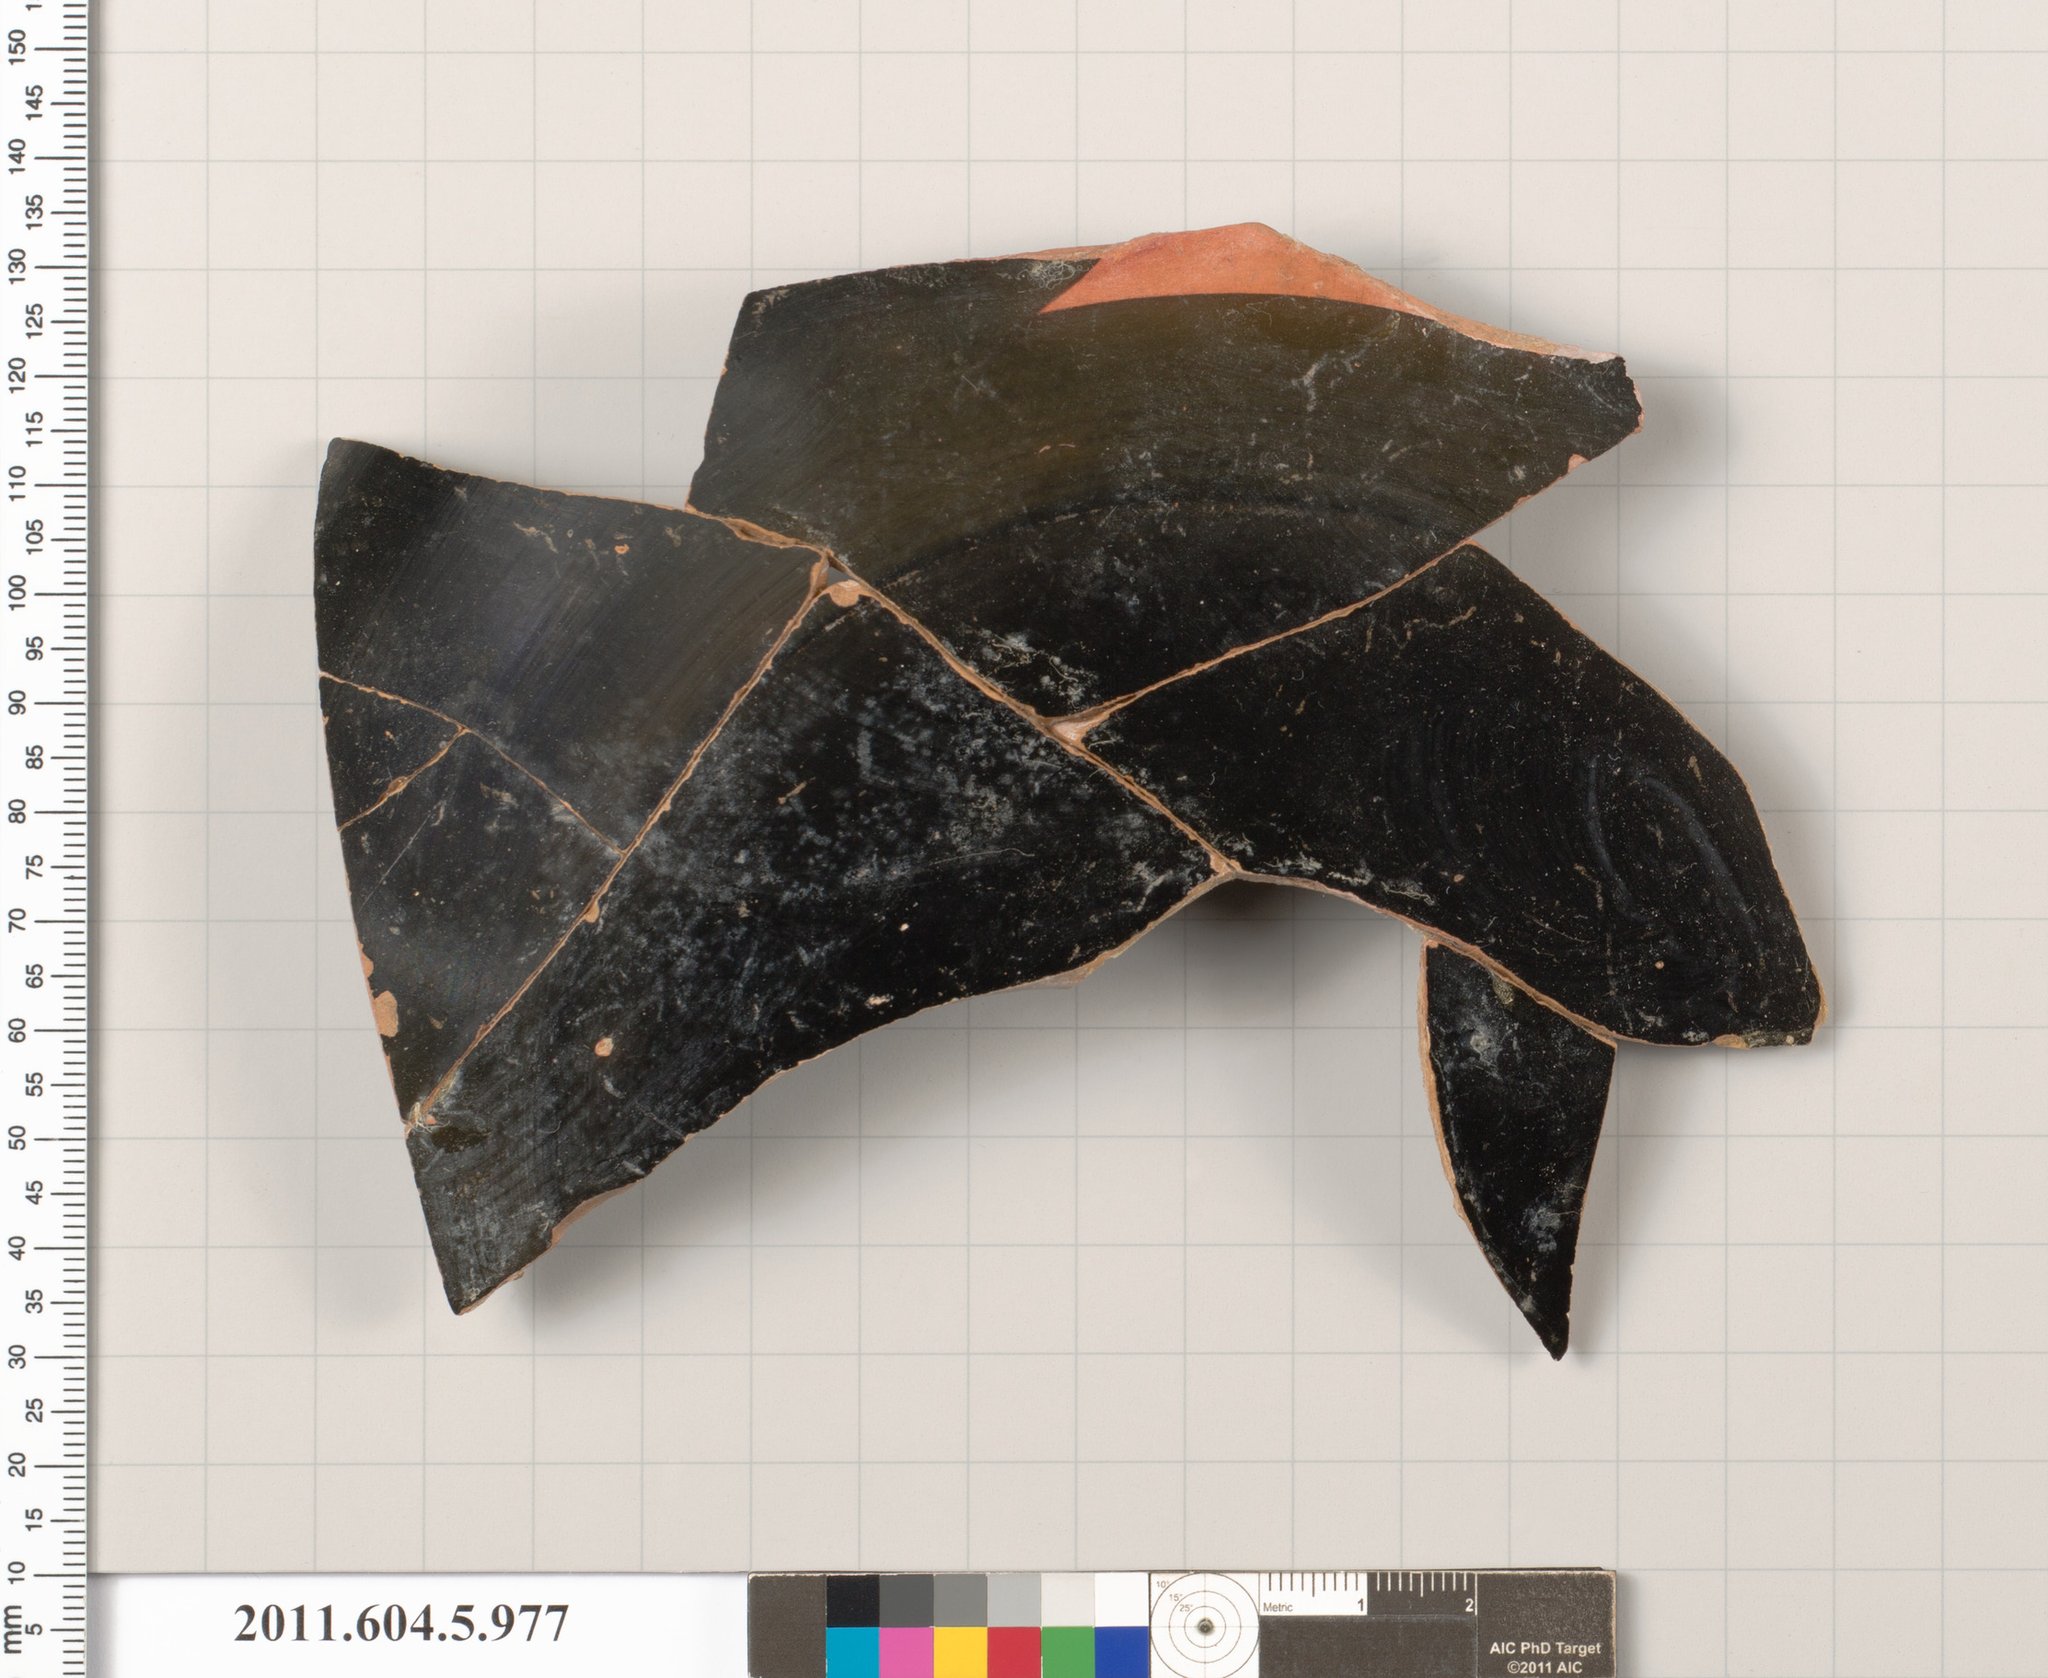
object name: kylix fragment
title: Terracotta fragment of a kylix (drinking cup)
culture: greek, attic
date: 600-401 BCE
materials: terracotta